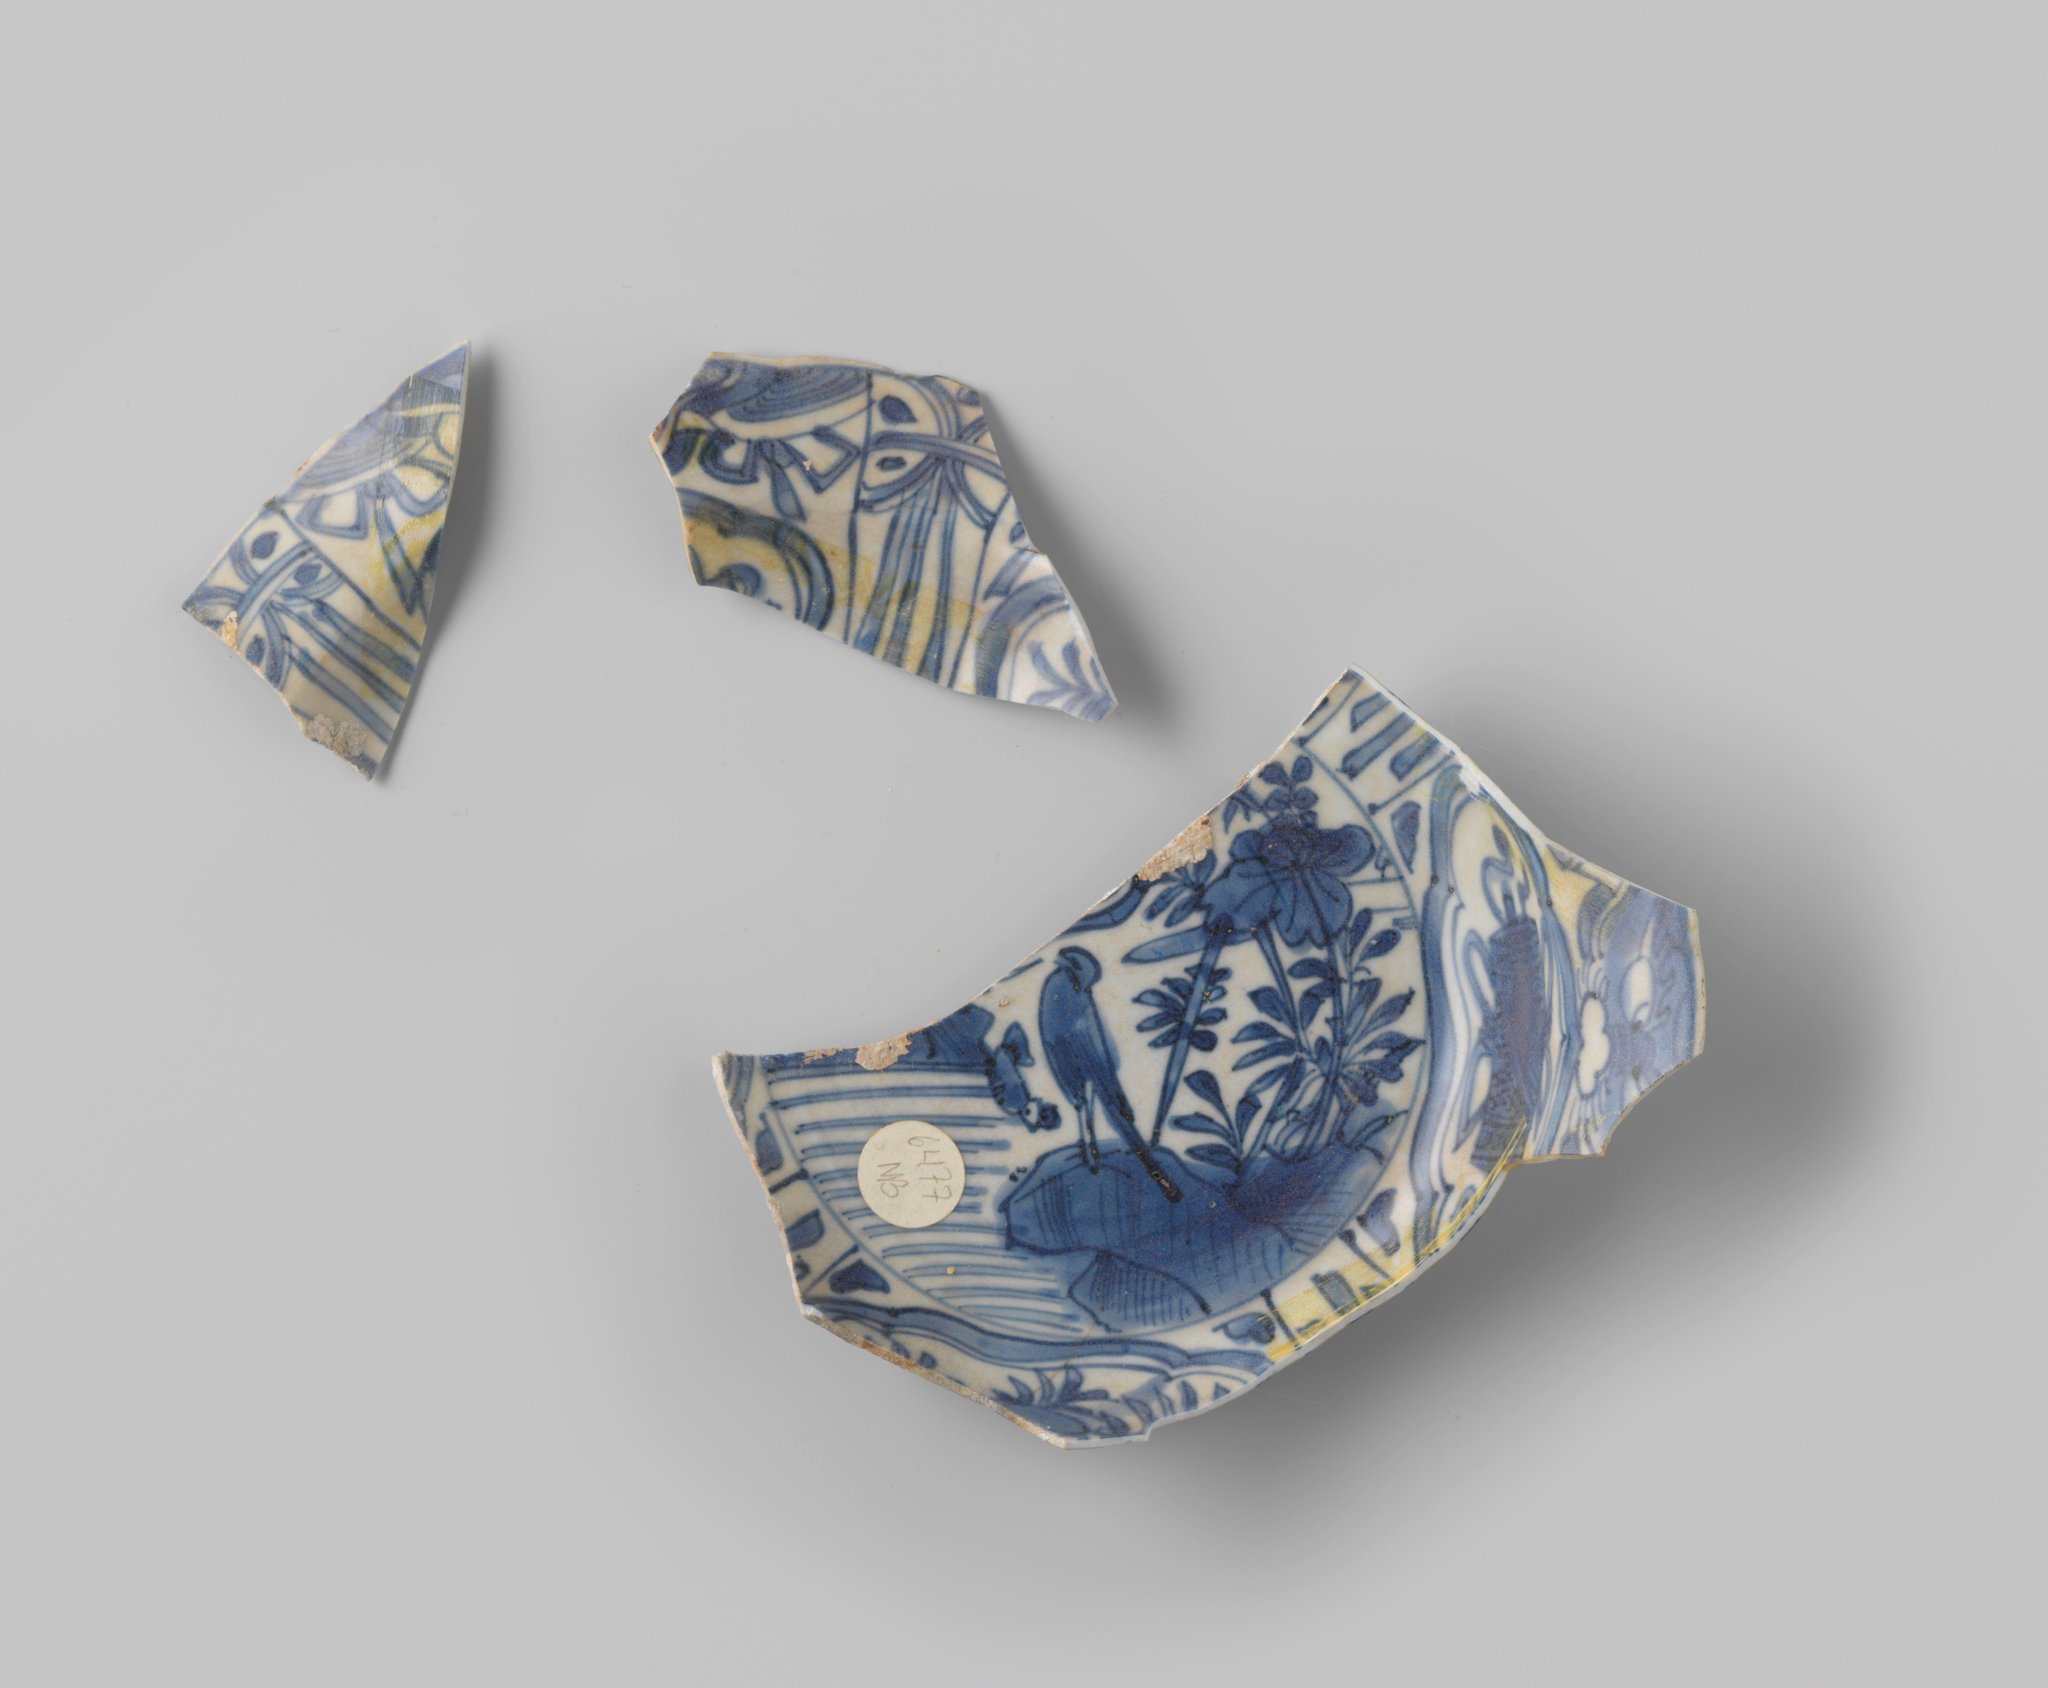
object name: plate dish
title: Scherven van diep bord uit V.O.C.-schip de 'Witte Leeuw'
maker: Anonymous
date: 1613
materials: bone china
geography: jingdezhen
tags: verenigde oostindische compagnie, sint-helena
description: A bowl with a flattened rim. Taotie mask and/or borders with diaper patterns. A central decoration of a grasshopper on a rock next to a peony. Panels decorated with flowers and fruits.